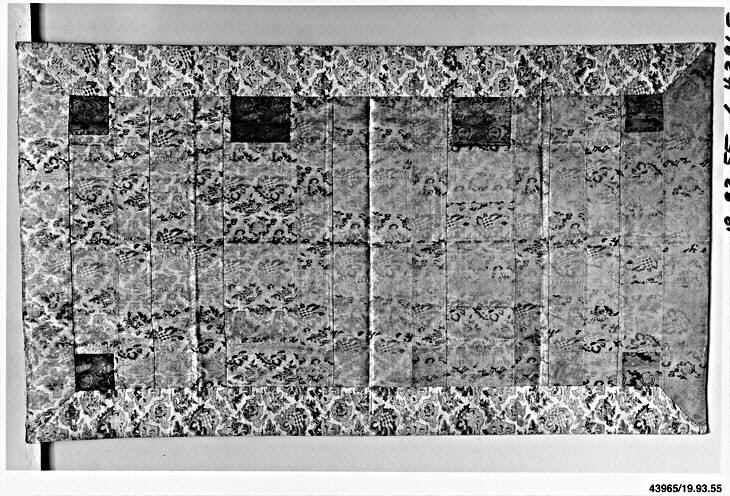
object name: robe, priest's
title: Priest's Robe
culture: japanese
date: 1573-1592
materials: silk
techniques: brocade